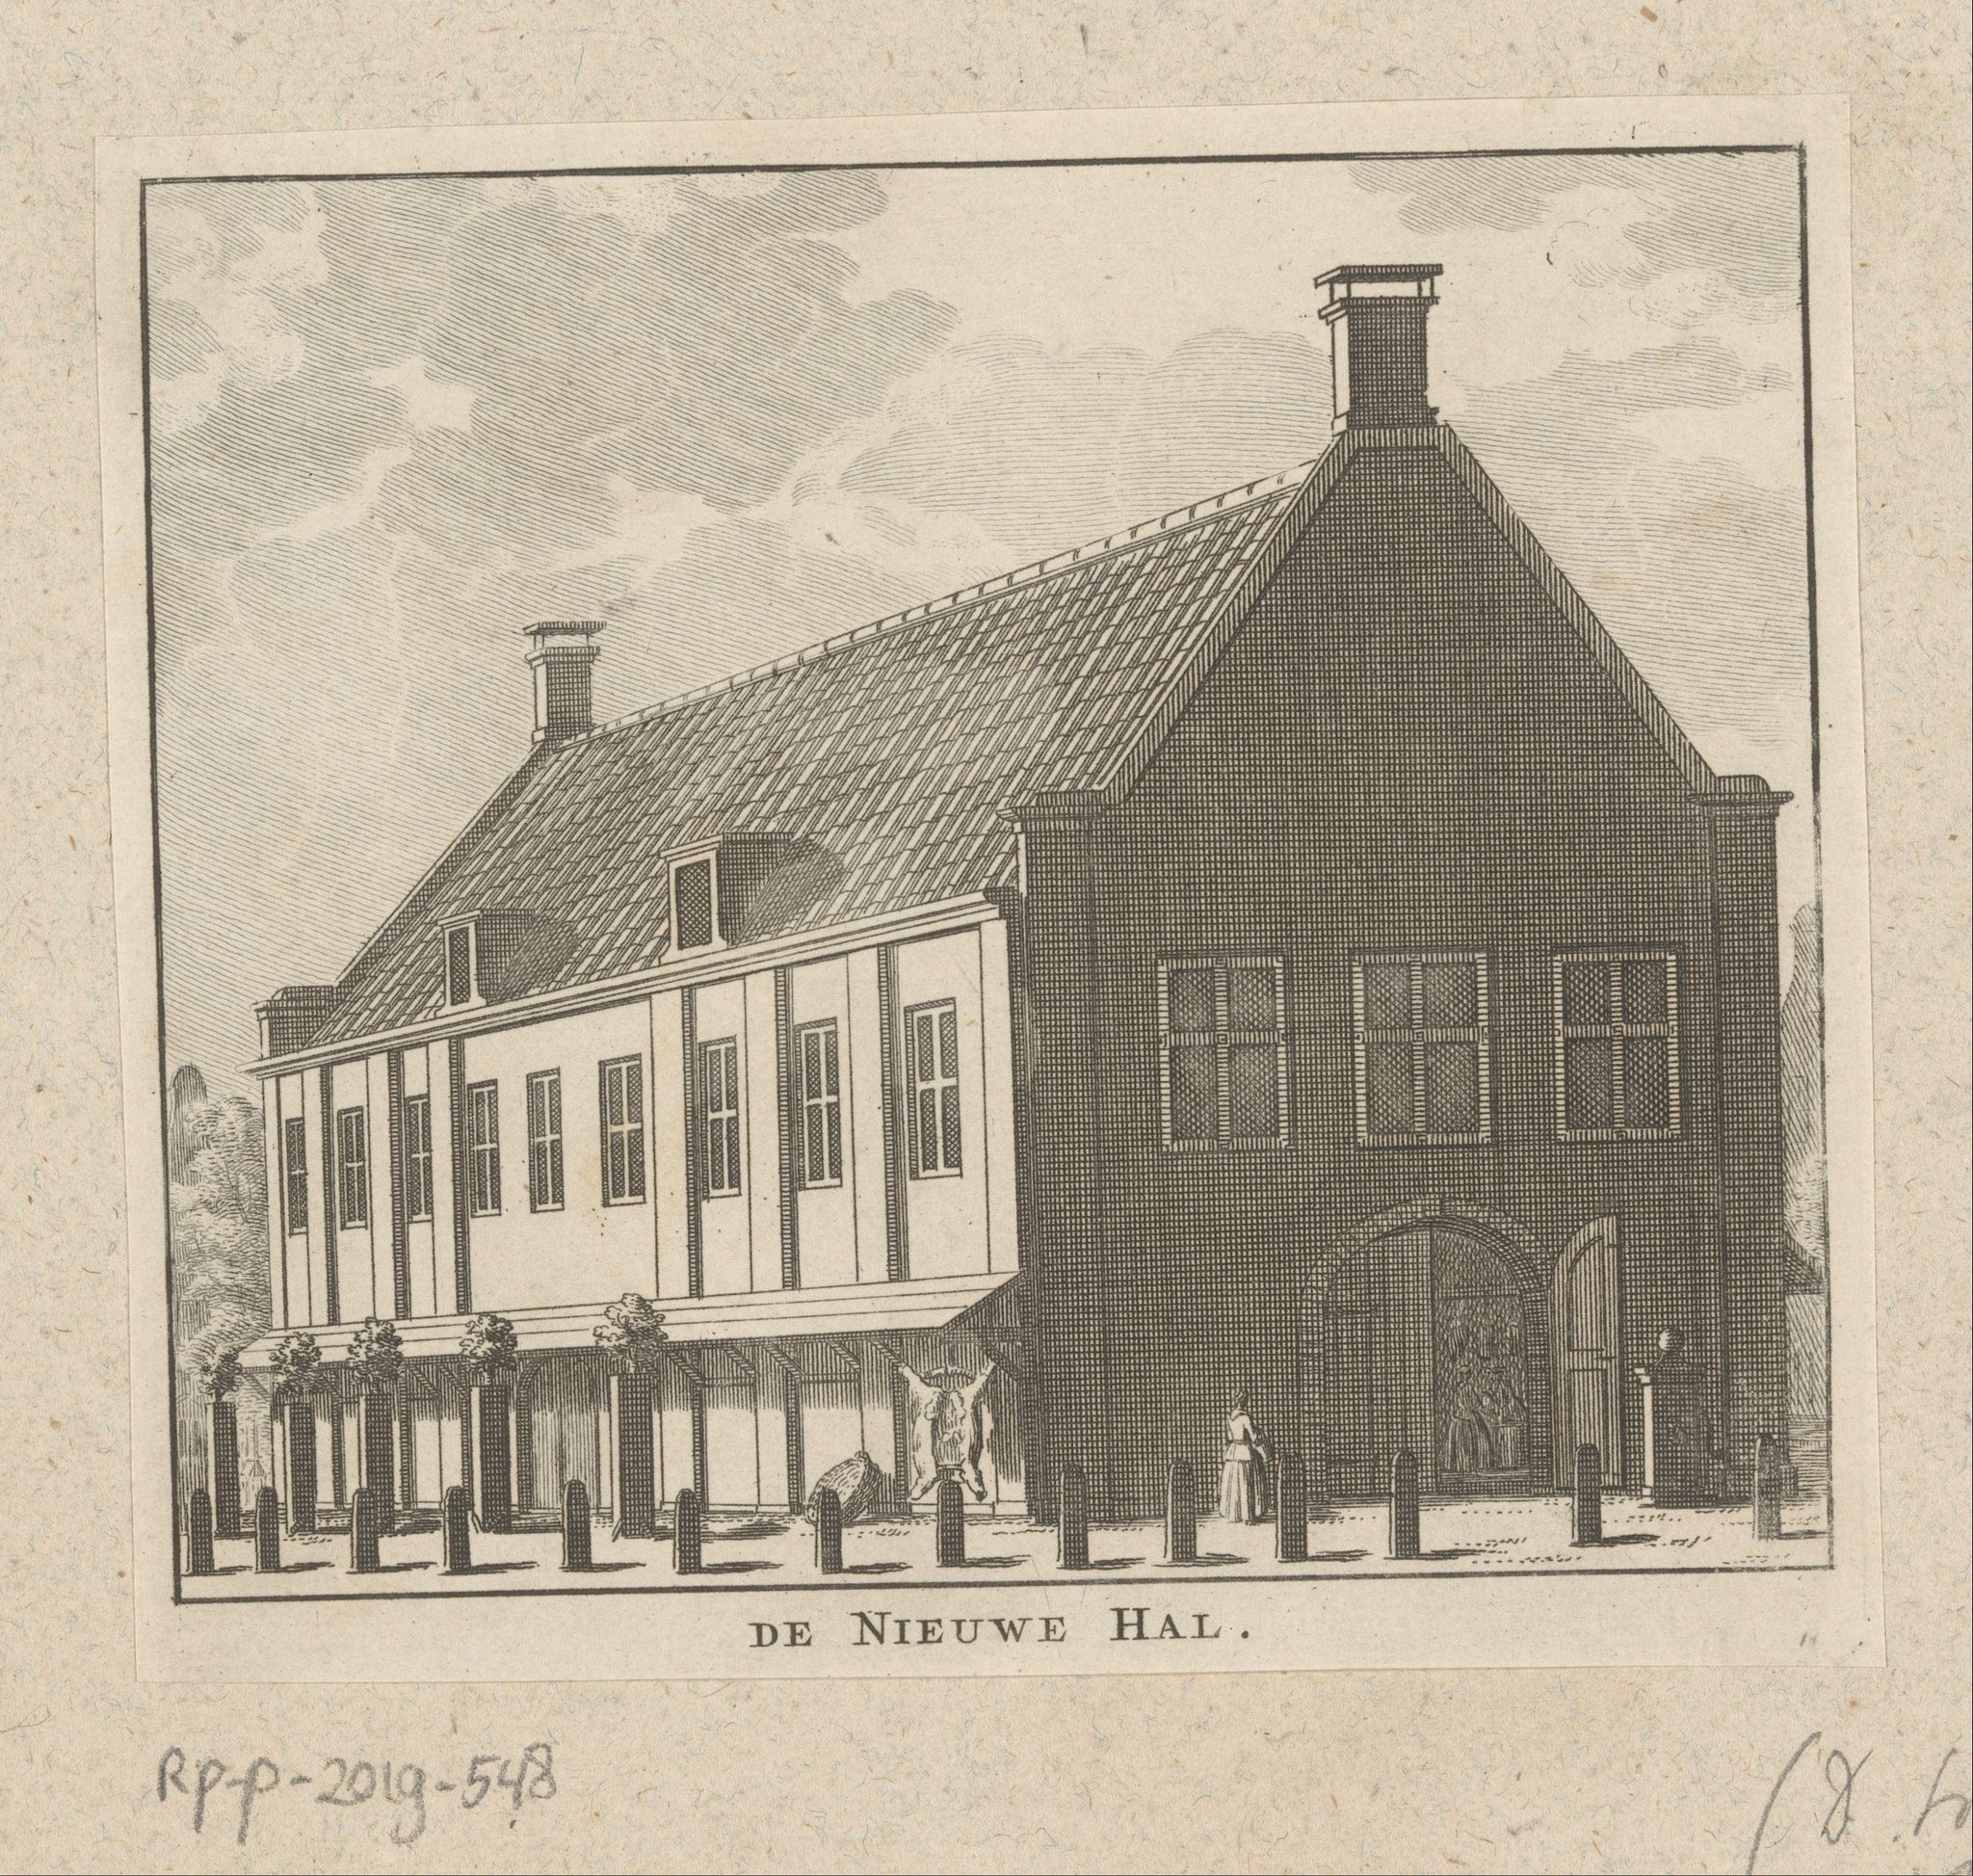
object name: print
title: Gezicht op de Vleeshal op de Botermarkt te Amsterdam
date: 1765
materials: paper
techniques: engraving, etching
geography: amsterdam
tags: market-hall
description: Prent uit: Wagenaar, Jan. Amsterdam, in zyne opkomst, aanwas, geschiedenissen (…). Amsterdam: Isaak Tirion, 1765, dl. 2.